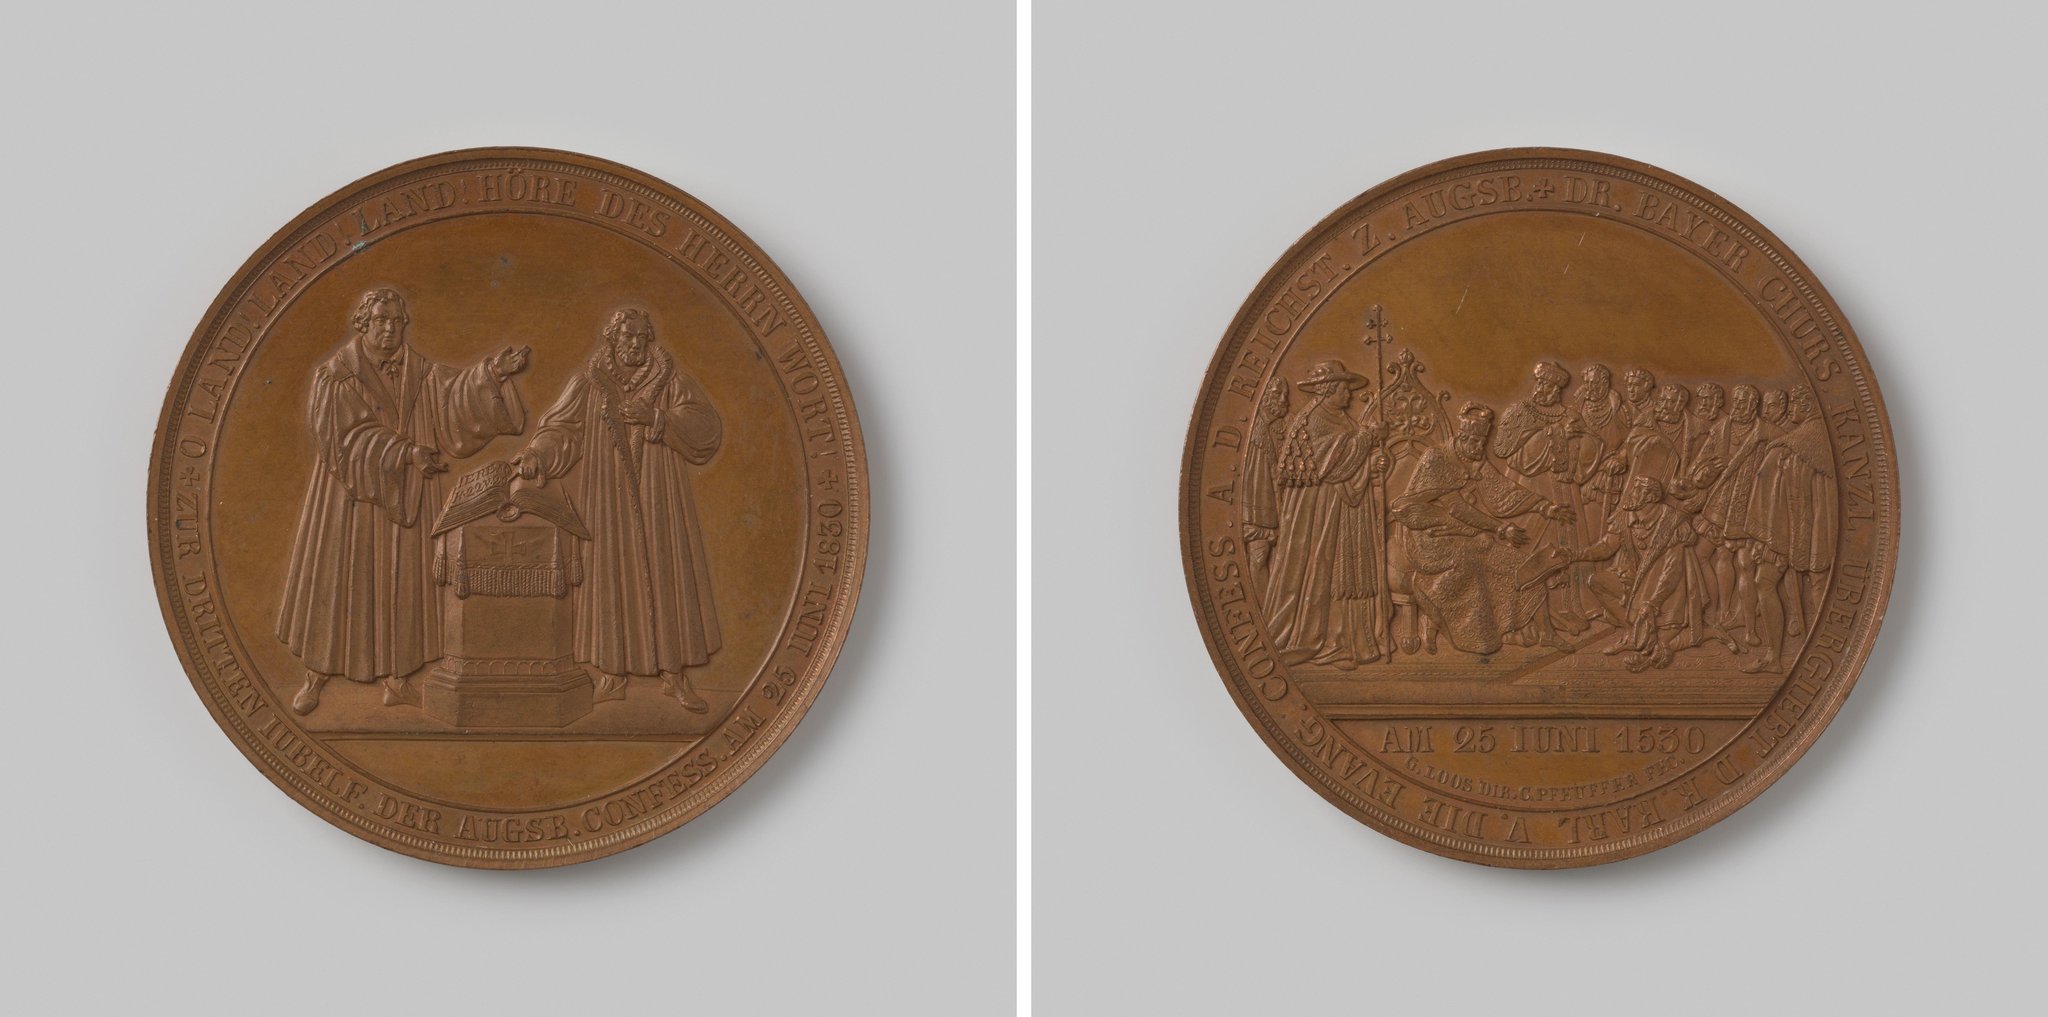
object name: history medal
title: Driehonderdjarige herdenking van het aanbieden van de Augsburgse Confessie 1830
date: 1830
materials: copper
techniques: striking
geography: berlin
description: Bronzen penning, op de voorzijde Luther en Melanchton bij een bijbel op een altaar, met omschrift, op de keerzijde de aanbieding van de confessie aan Keizer Karel V, met omschrift en afsnedetekst.